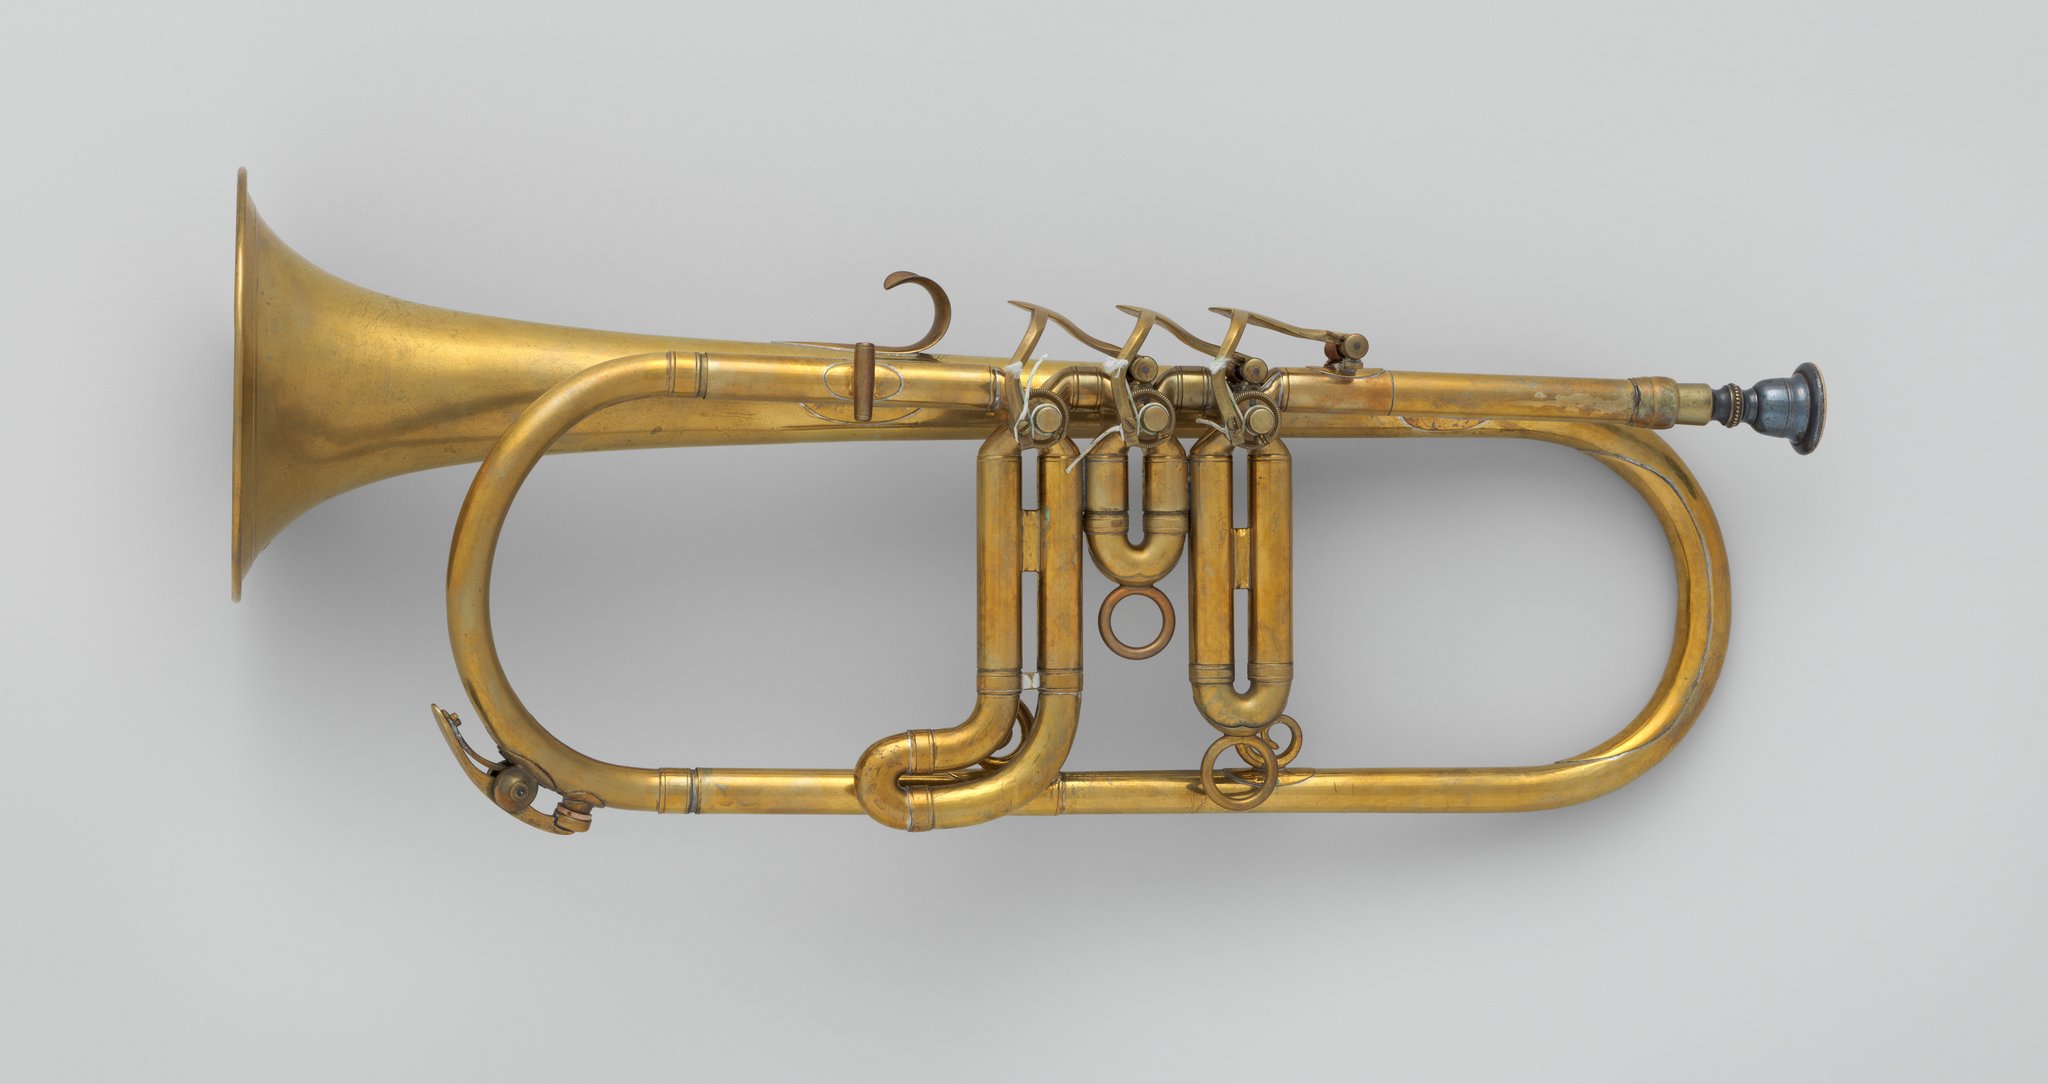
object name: valve trumpet in b flat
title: Valve Trumpet in B-flat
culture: american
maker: david c. hall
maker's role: manufacturer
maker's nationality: american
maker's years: 1822-1900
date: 1862-1865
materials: brass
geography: united states